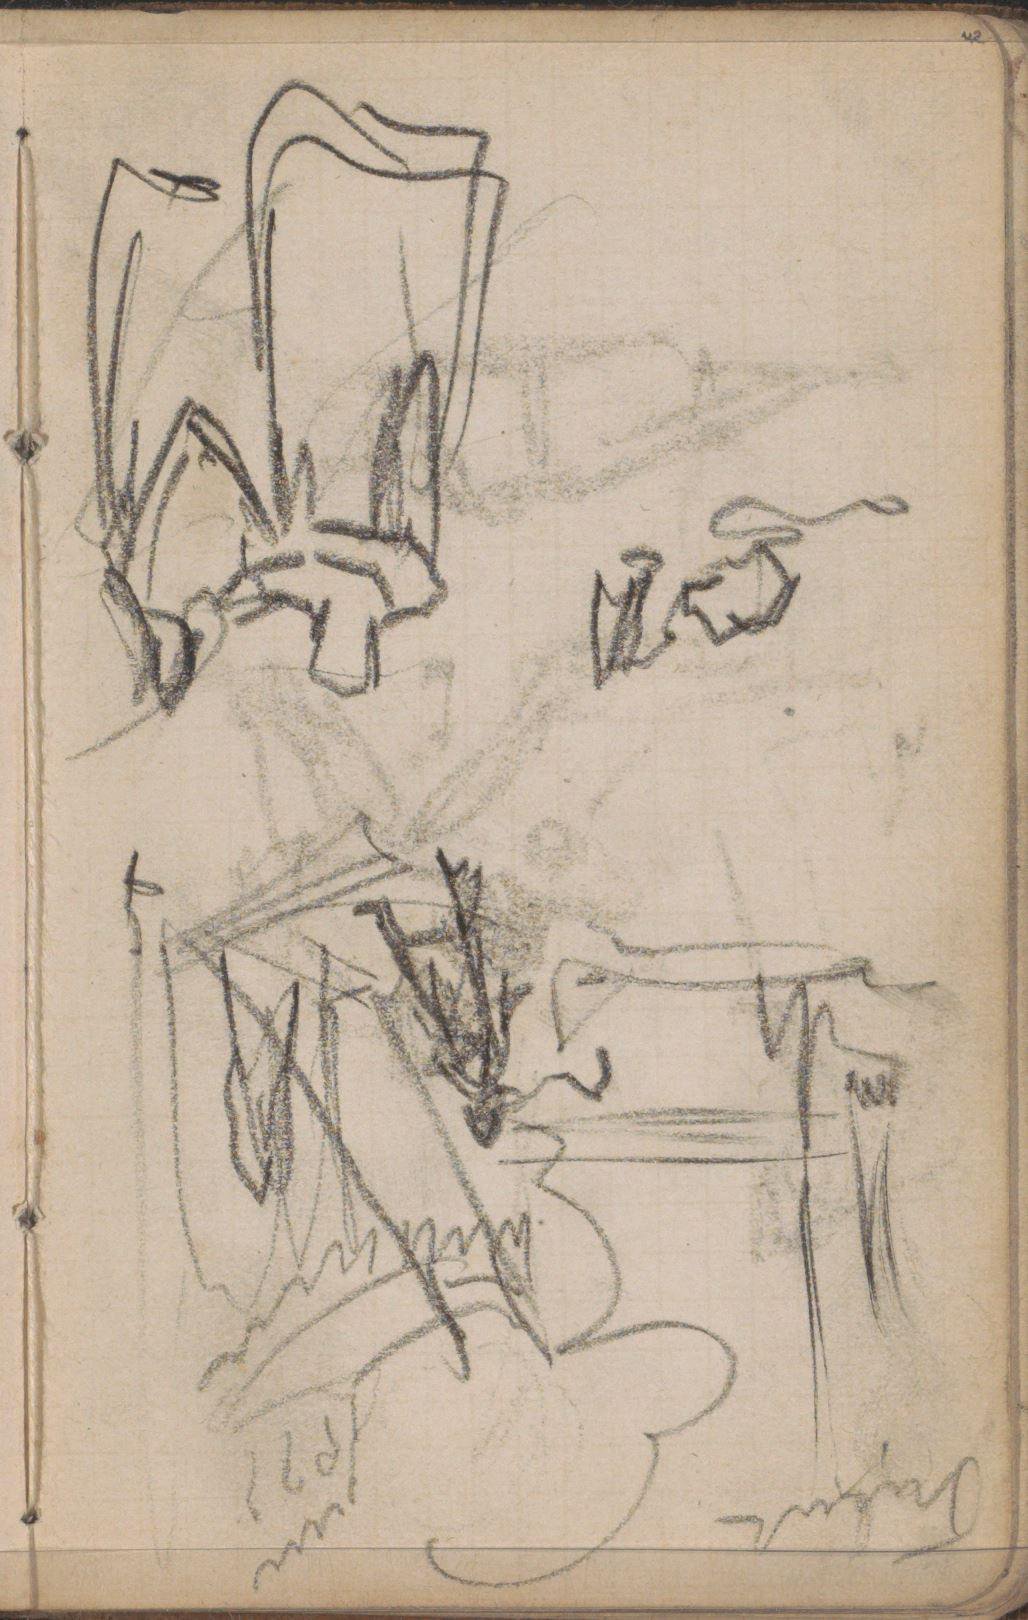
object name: sketchbook leaf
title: Studieblad, onder andere met een figuur bij een poort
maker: marius bauer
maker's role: draughtsman, print maker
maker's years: 1867-1932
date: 1879-1885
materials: chalk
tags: standing figure, arch, archivolt ~ architecture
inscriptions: annotation: ‘Tribu[..]t’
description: Pagina 42 uit een schetsboek met 58 bladen.